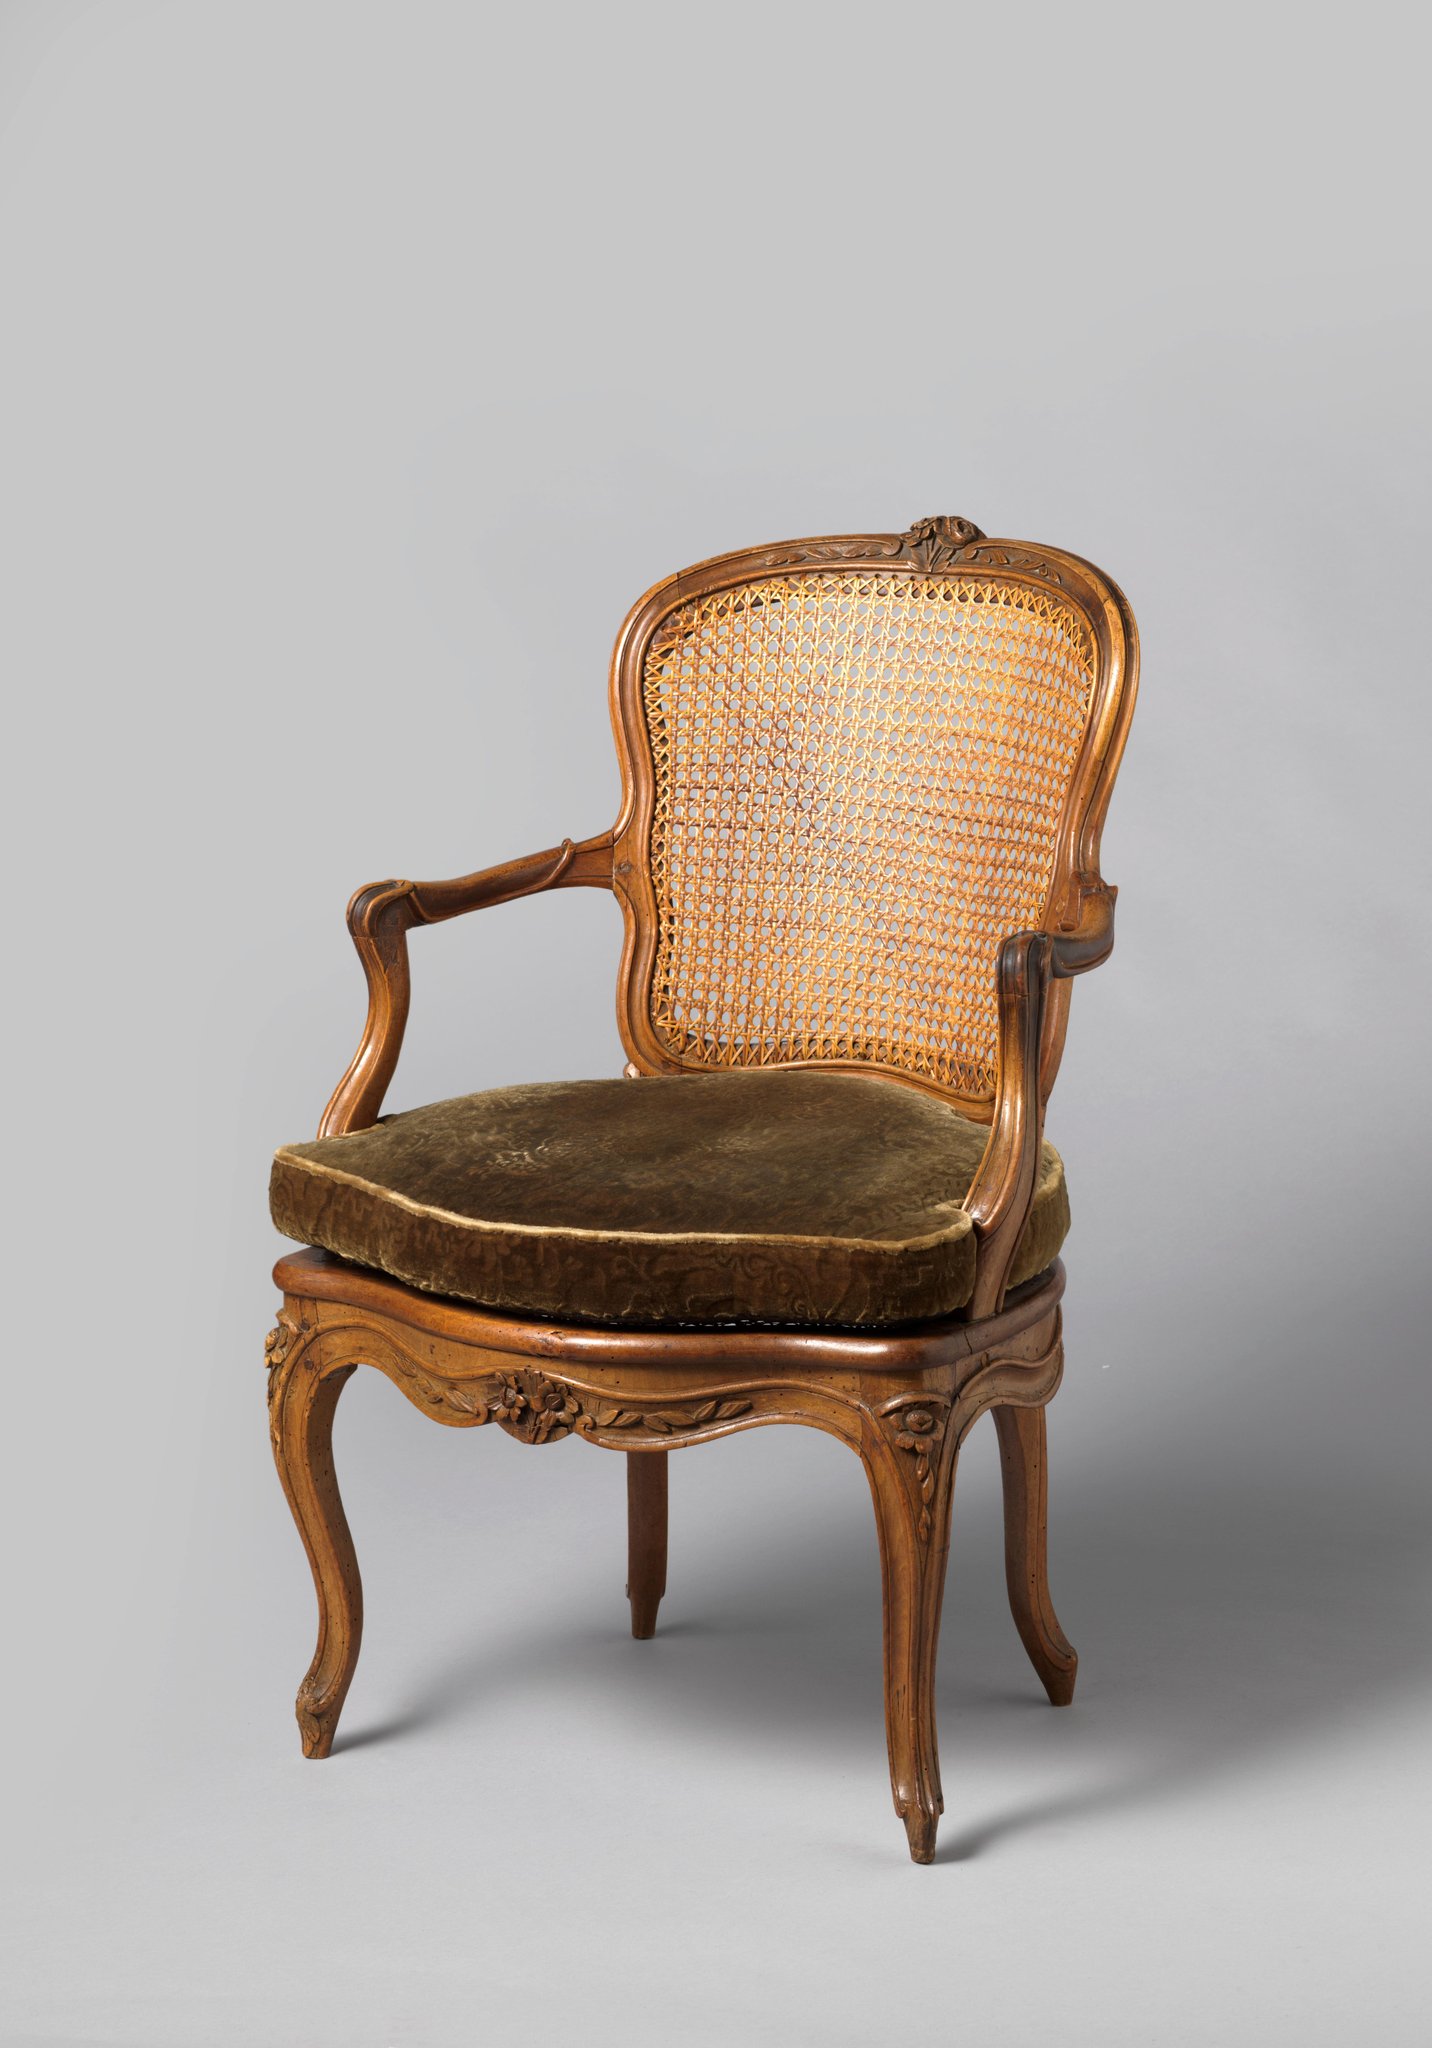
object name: furniture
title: Armstoel van notenhout met S-vormige overhoeks geplaatste poten met snijwerk van bloemen en bladeren. Rug en zitting van gevlochten riet. Met los kussen.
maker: Anonymous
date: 1750-1775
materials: wood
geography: france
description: Armstoel van notenhout (ameublement) met rug en zitting van gevlochten riet. De gestrekt S-vormige overhoeks geplaatste poten met profilering gaan zonder onderbreking in het zitraam over en zijn versierd met gestoken bloemen. Geschulpte voorregel met bloem- en bladwerk. Achterwaarts geplaatste armleggerstutten S-vormig; geholde armleggers eindigend in voluten. Bovenregel raam met gestoken voluten. Met los kussen. Zie ook BK-16851-A t/m H.